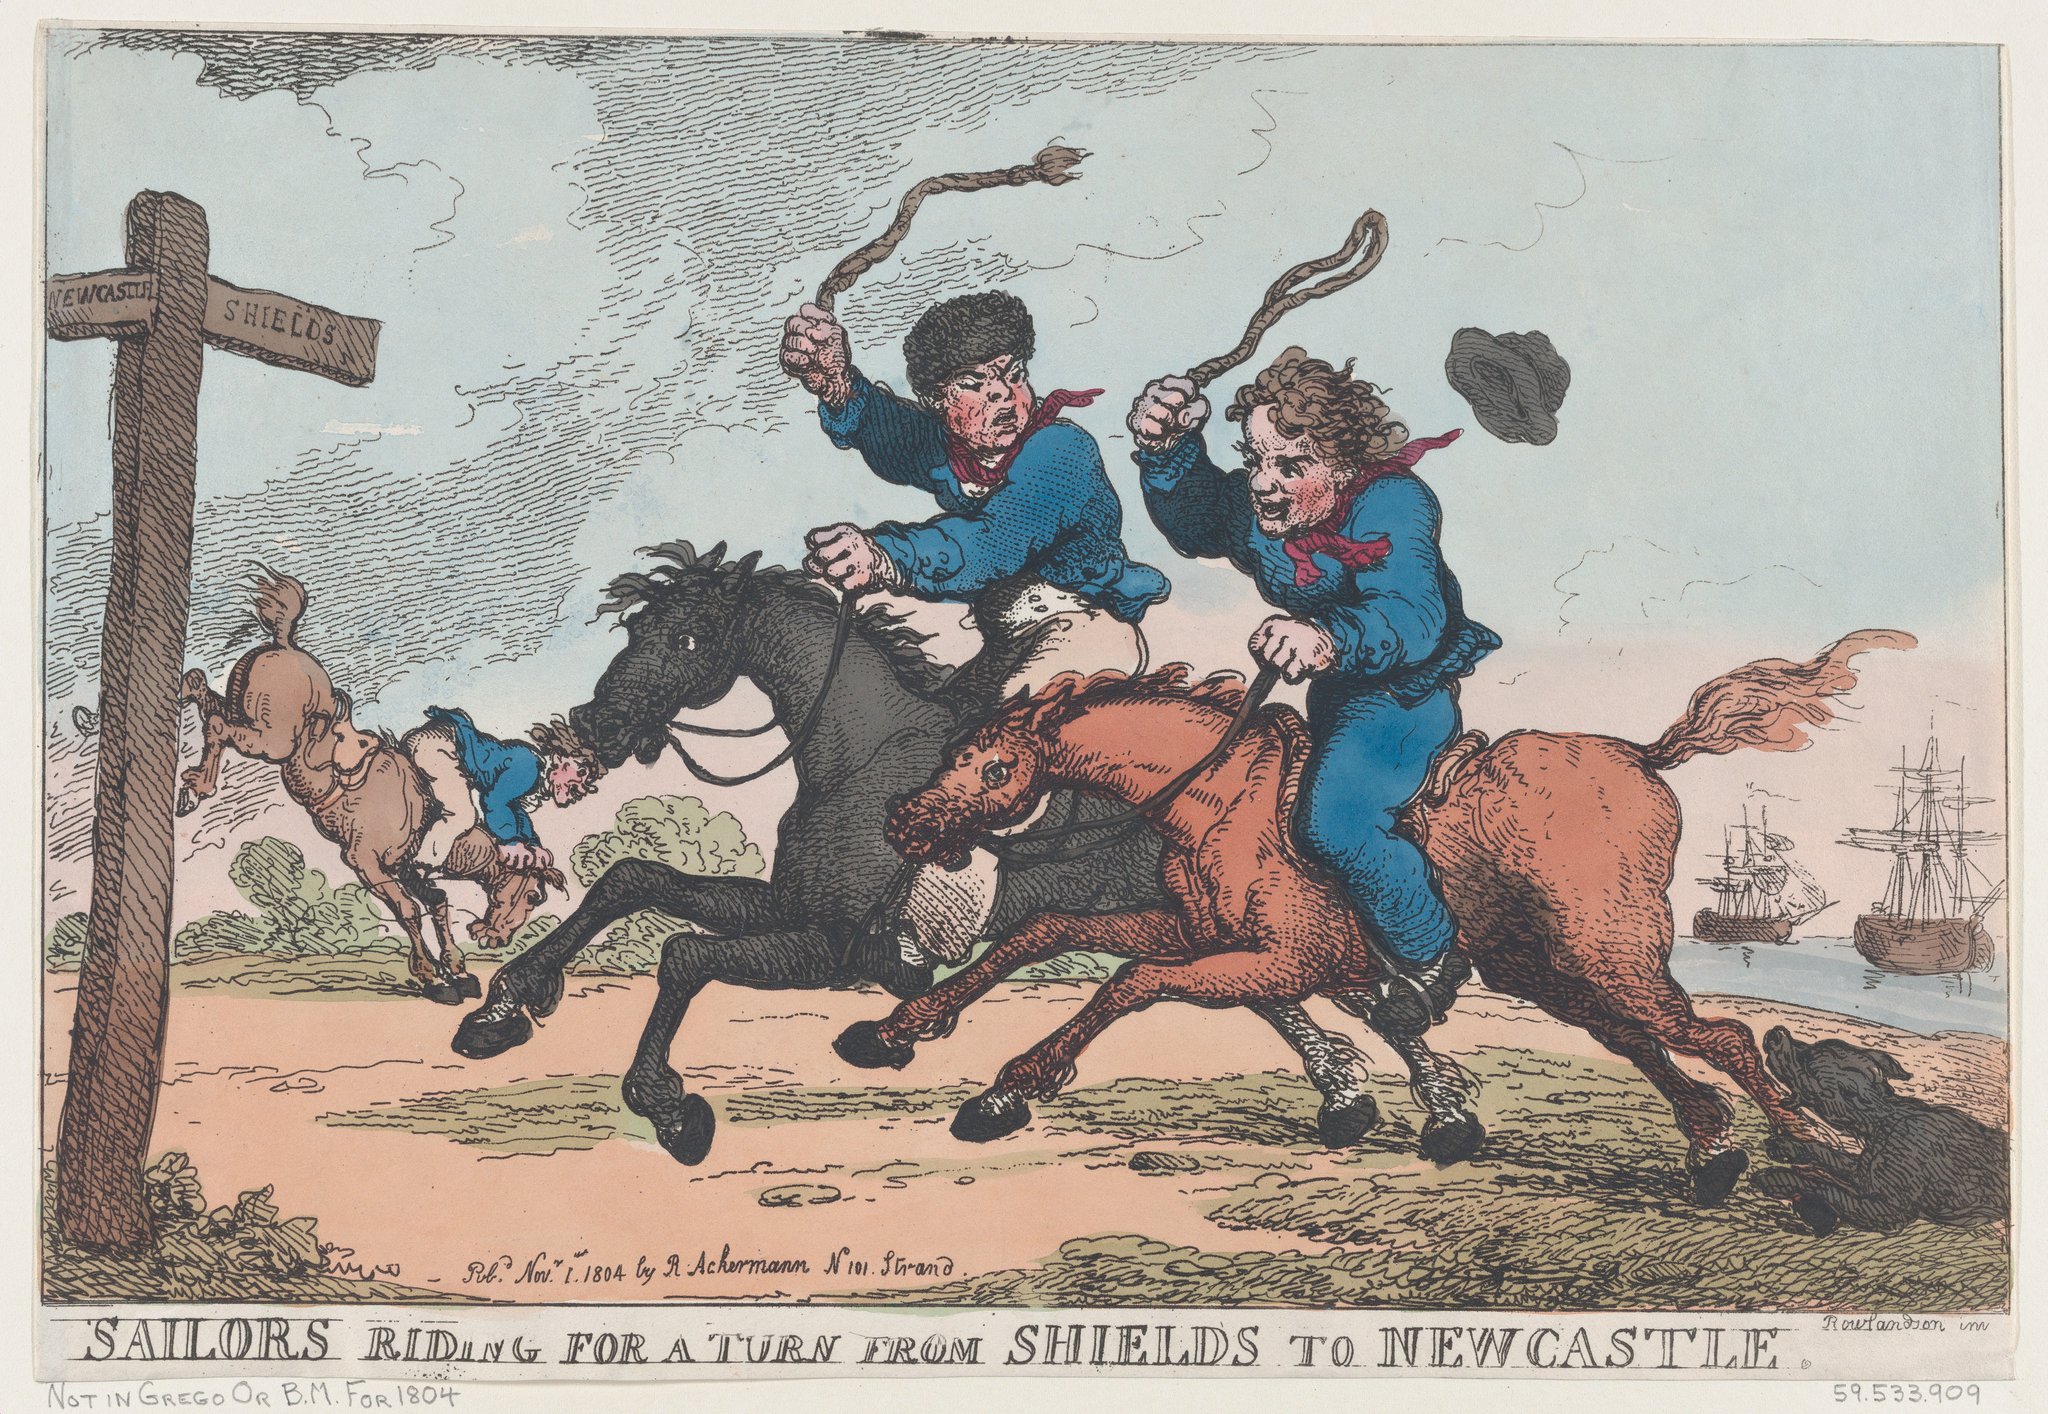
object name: print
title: Sailors Riding For A Turn From Shields to Newcastle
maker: thomas rowlandson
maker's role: artist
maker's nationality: british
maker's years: 1757-1827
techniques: etching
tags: satire,men,horses